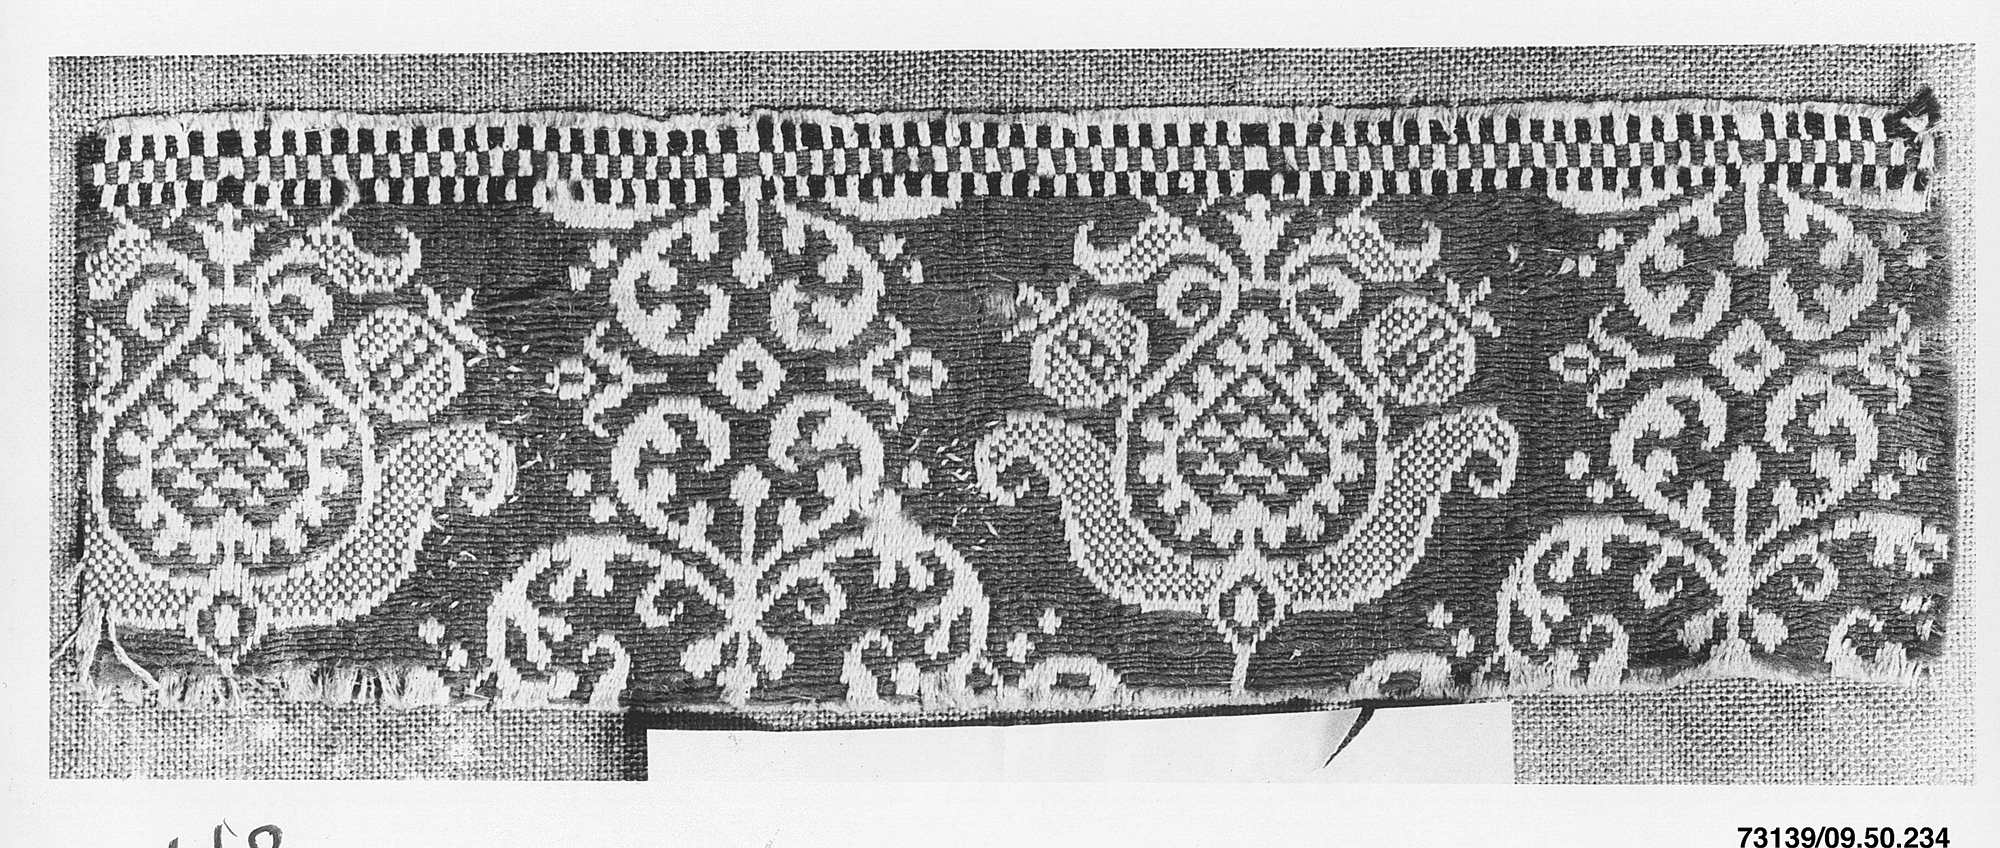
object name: fragment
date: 1801-1900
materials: linen, wool